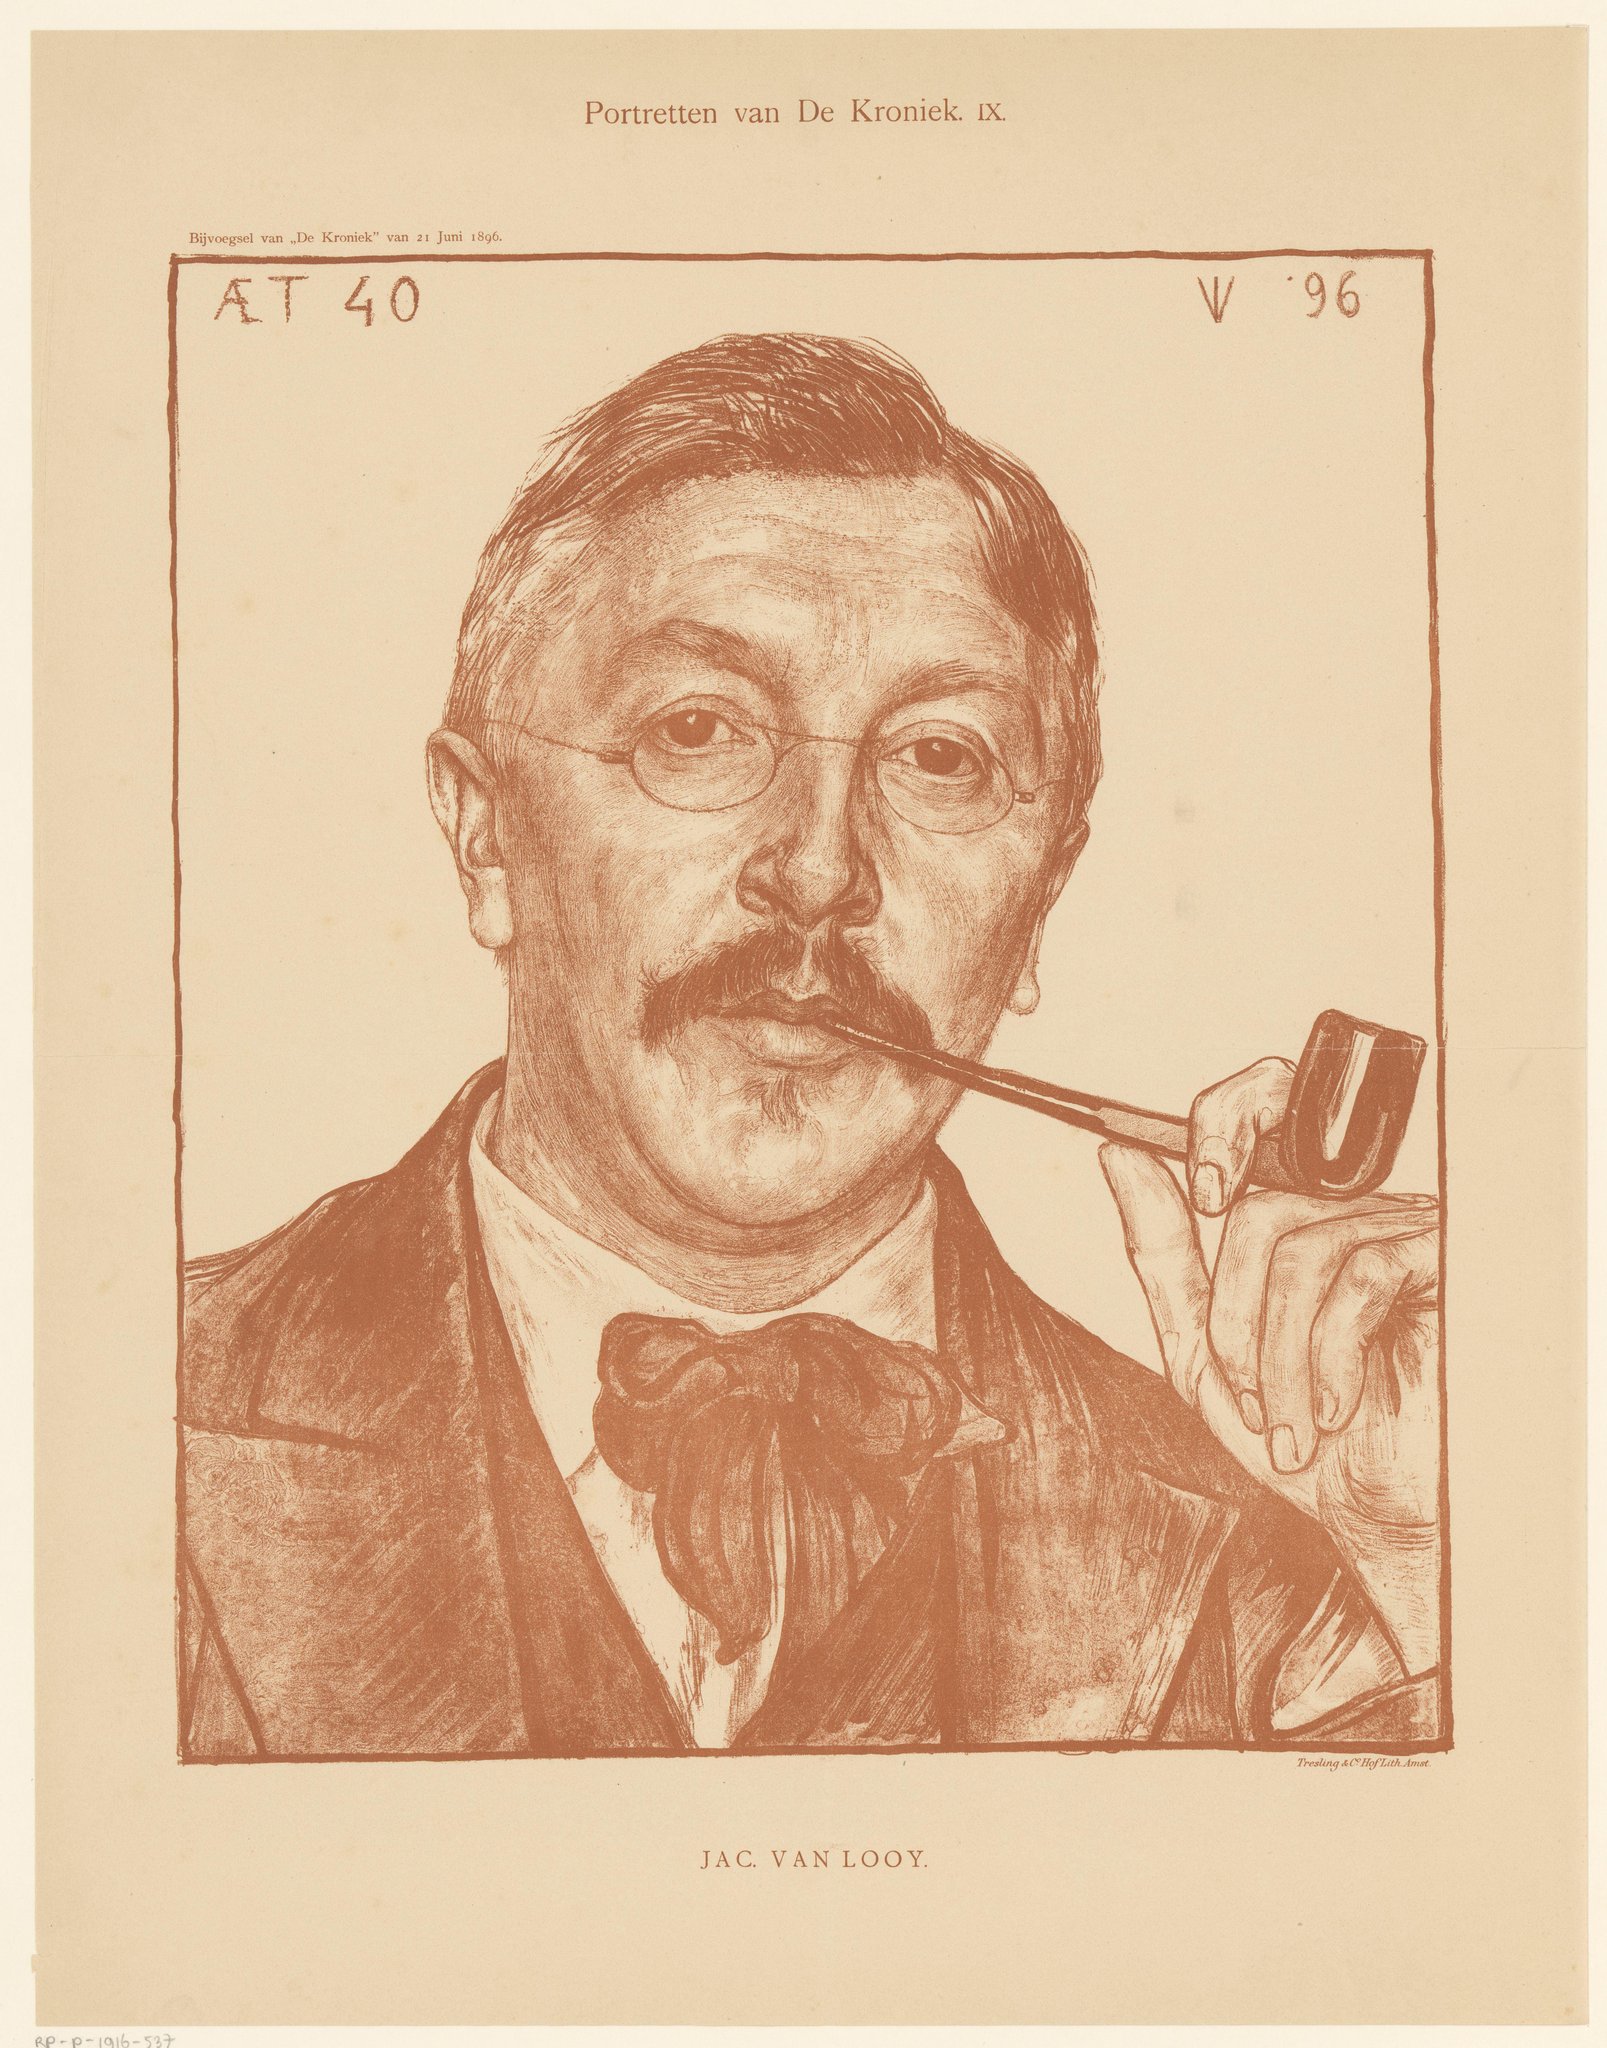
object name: print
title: Portret van Jac van Looij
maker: jan veth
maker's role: designer, draughtsman, painter, print maker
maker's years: 1864-1925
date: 1896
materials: paper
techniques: lithograph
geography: amsterdam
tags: haarlem, painter, print maker, draughtsman, jac van looij, pipe ~ tobacco, historical persons (+ (full) bust portrait)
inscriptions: collector's mark: Lugt 2228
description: Deze prent werd uitgegeven bij De Kroniek op 21 juni 1896.